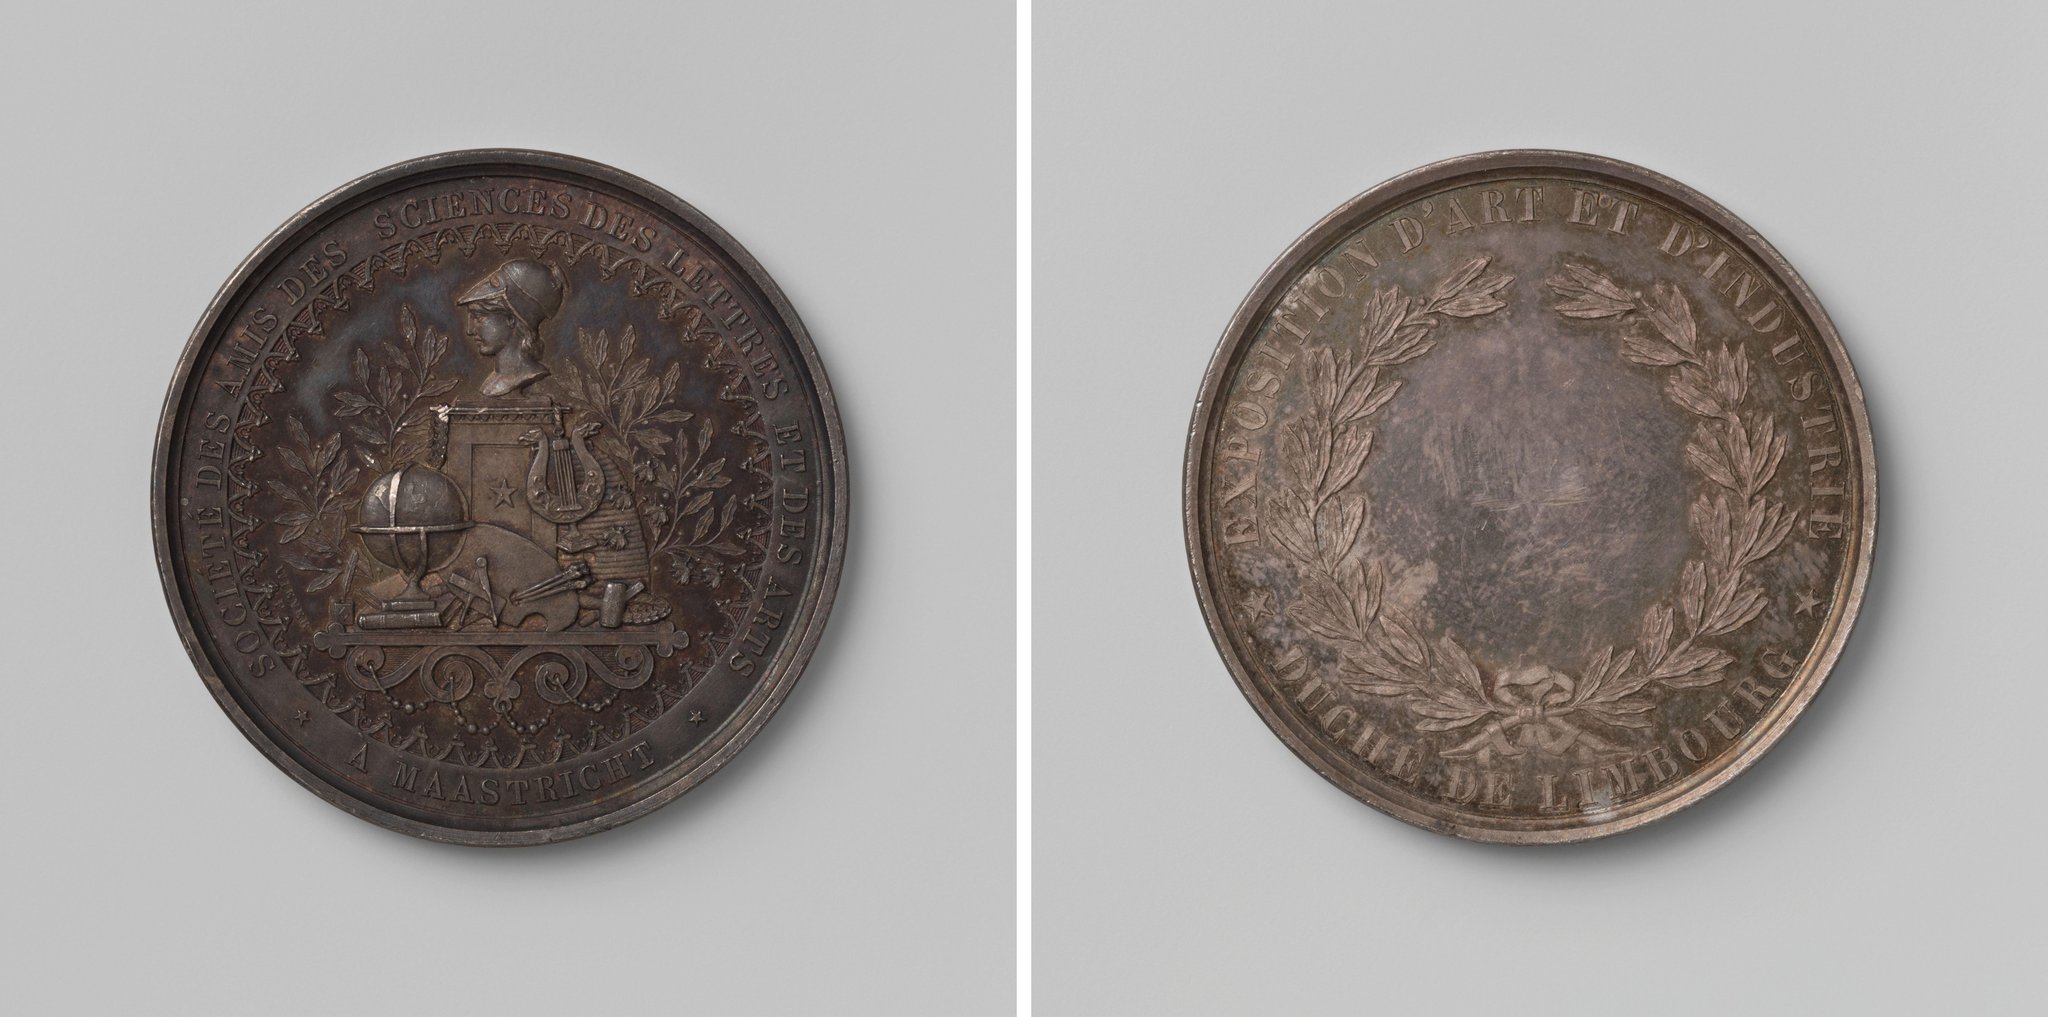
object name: medal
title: Tentoonstelling van voortbrengselen van kunst en nijverheid uit Limburg te Maastricht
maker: jacob wiener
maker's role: medailleur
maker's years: 1815-1899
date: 1841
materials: silver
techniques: striking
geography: brussels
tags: maastricht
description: Zilveren penning. Voorzijde: globe, schilderspalet met penselen, bijenkorf, inktkoker, boeken, passer, driehoek, steenhouwershamer, beitel en lier, verzameld rond sokkel, waarop borstbeeld van Minerva staat, omgeven door olijftakken binnen Gothische sierrand en omschrift. Keerzijde: blanco veld binnen krans van olijftakken en omschrift